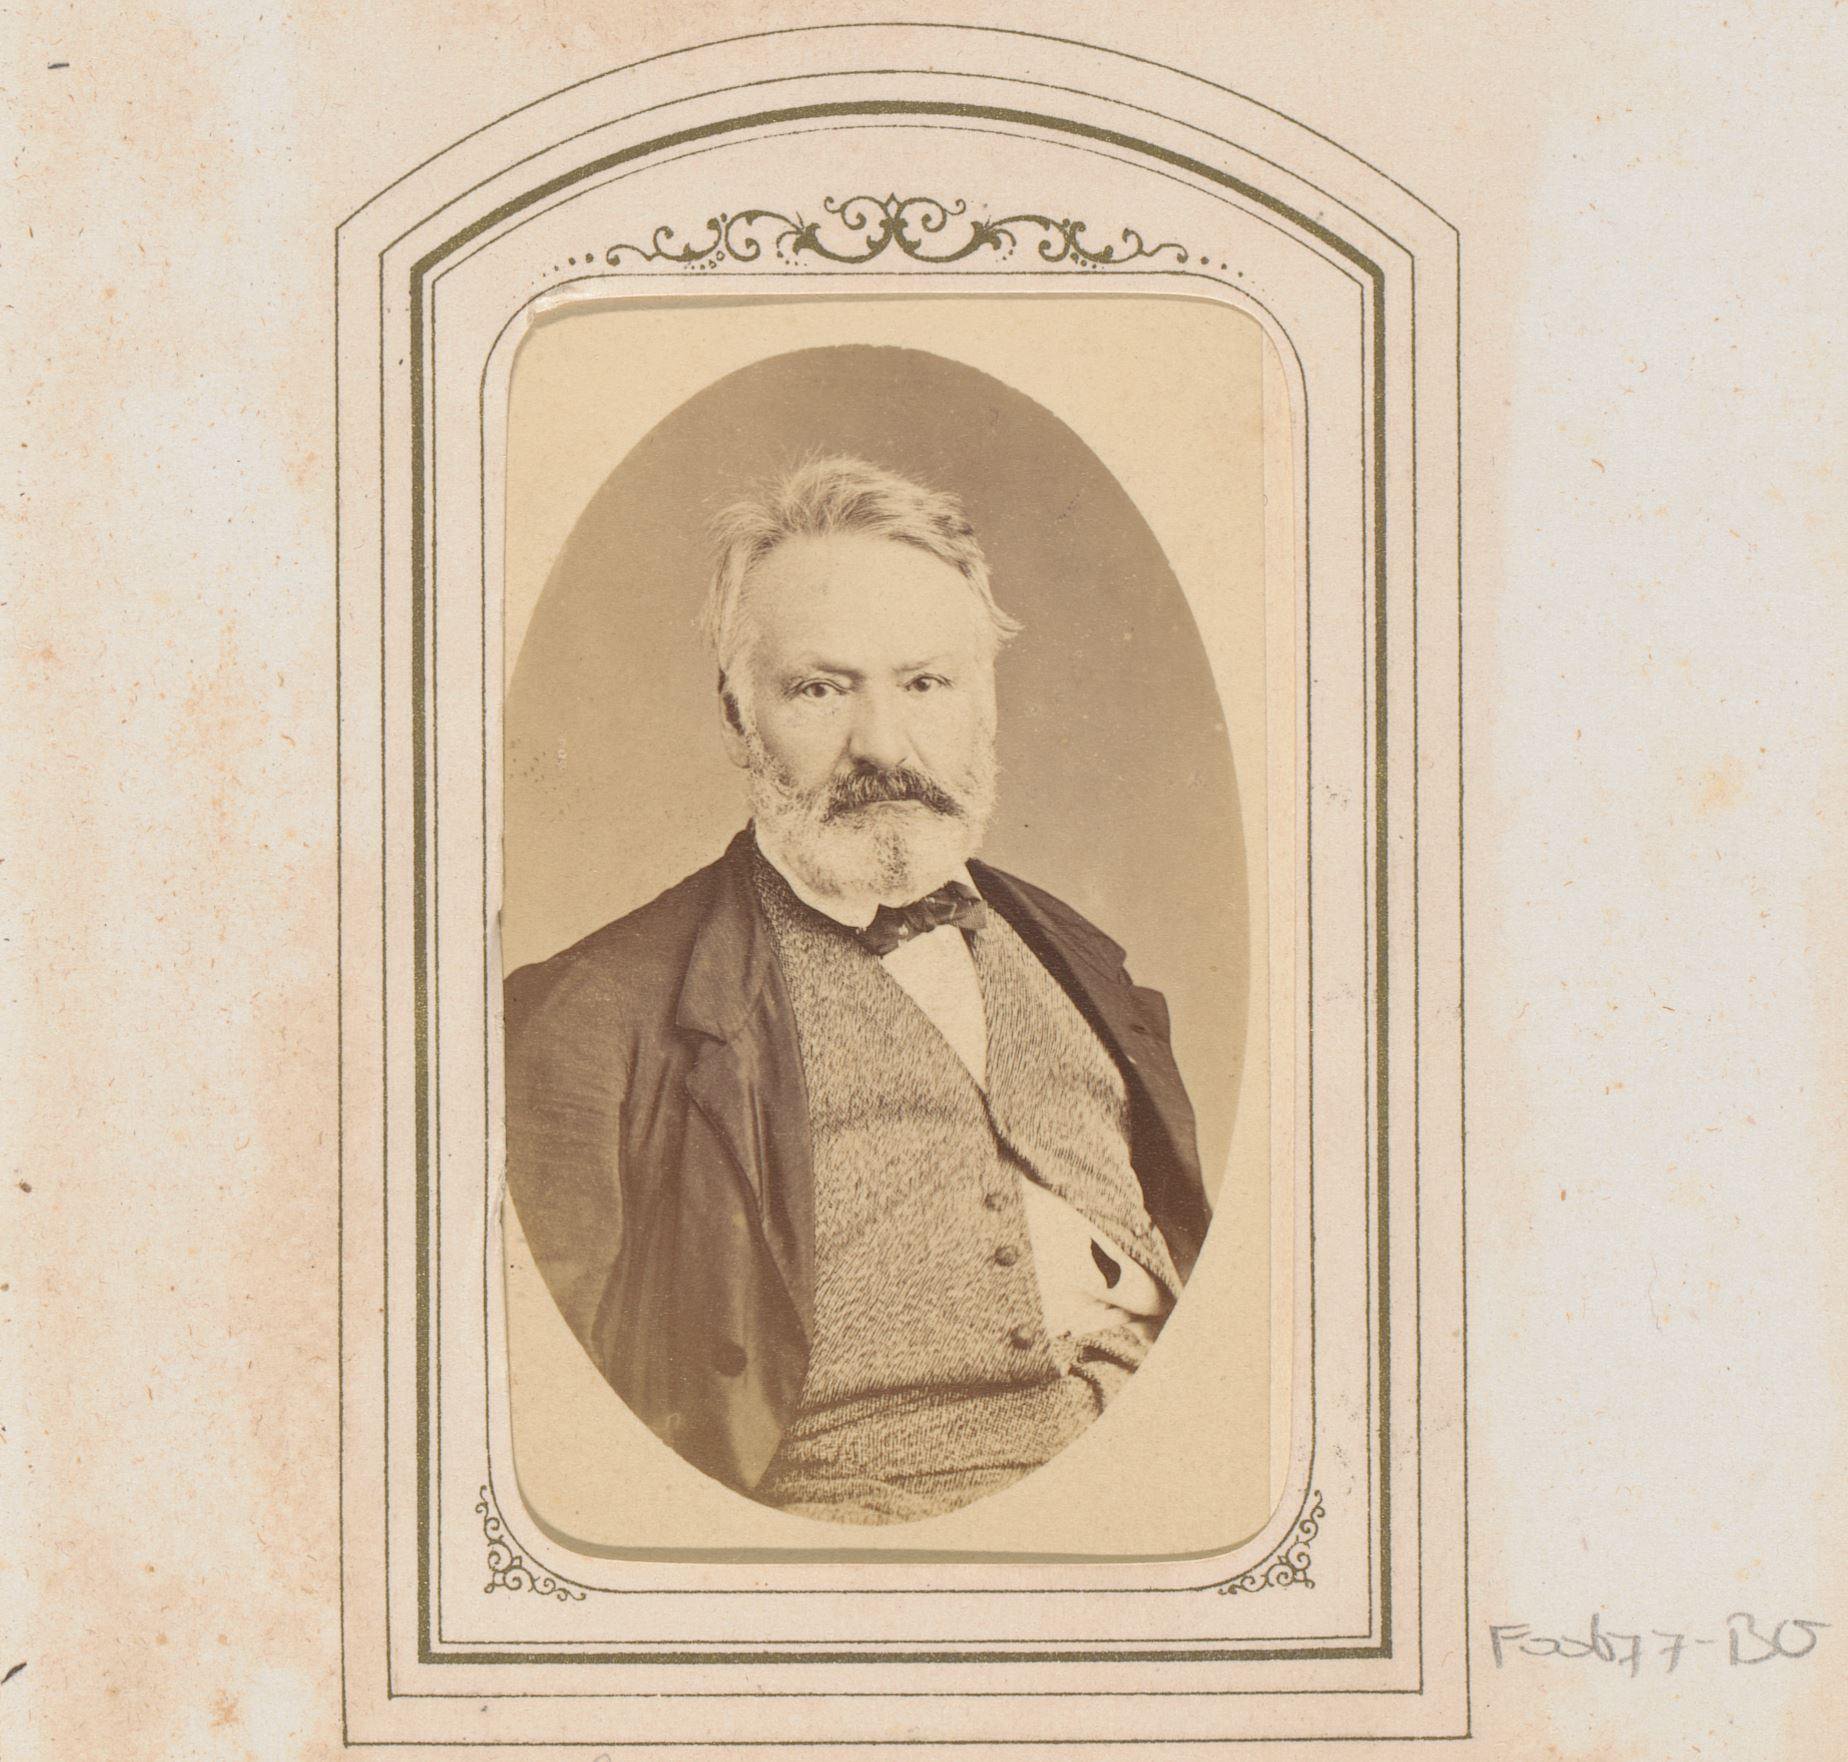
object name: album leaf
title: Portret van Victor Hugo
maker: albert delabarre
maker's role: musician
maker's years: 1809-1885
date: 1855-1870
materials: cardboard, photographic support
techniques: albumen print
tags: paris, victor hugo, historical persons, portrait of a writer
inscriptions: name: ‘Victor Hugo’, annotation: ‘Victor Hugo 1802/85’, number: ‘15’, inscription: ‘PHOTOGRAPHIE PARISIENNE/ 36, Rue Fossé aux Loups, 36./ (Place de la Monnaie)/ BRUXELLES./ Les clichés sont conservés.’